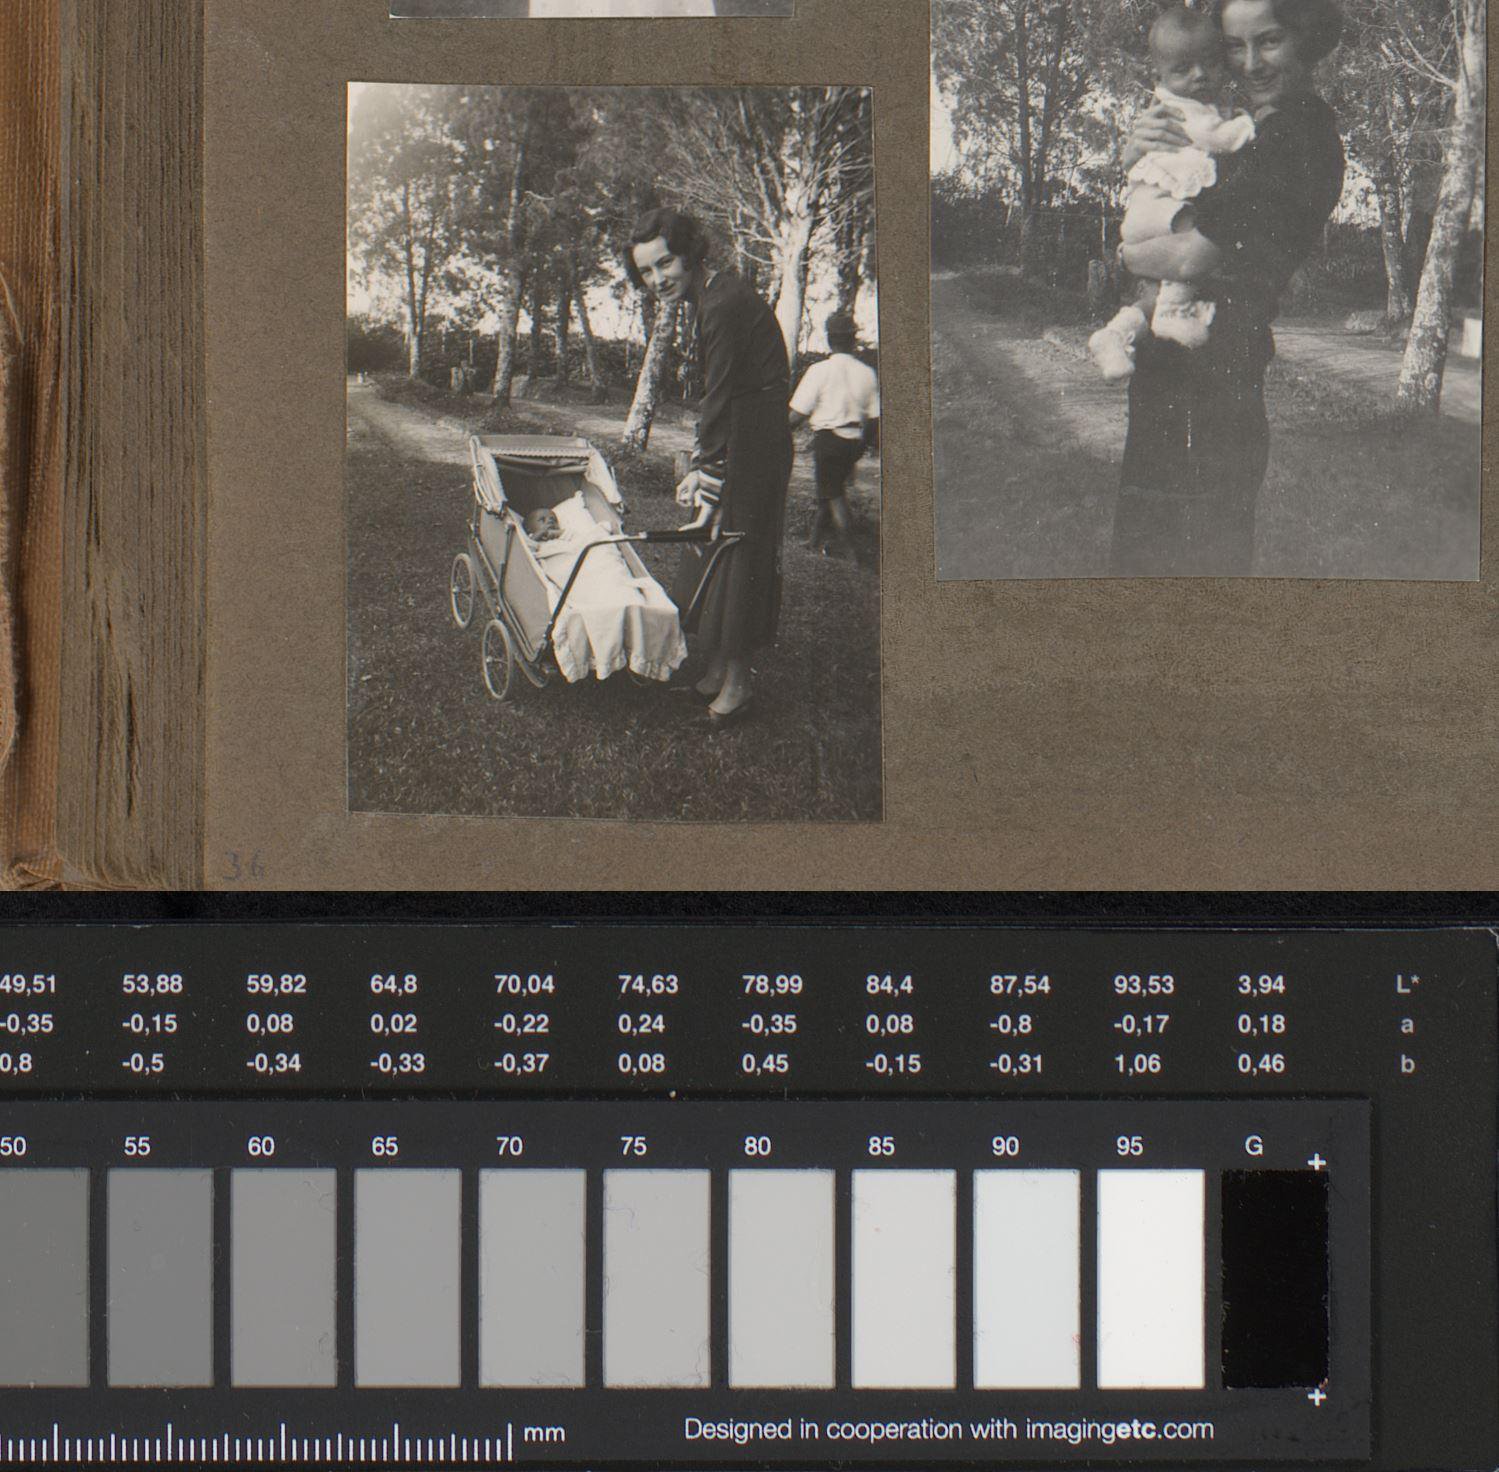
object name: photograph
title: Portret van Ada Krüseman met Teddy in een kinderwagen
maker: Anonymous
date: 1907-1934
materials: paper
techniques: gelatin silver print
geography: dutch east indies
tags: baby-carriage, pram, perambulator, historical persons - bb - woman, mother and baby or young child, dutch east indies, the